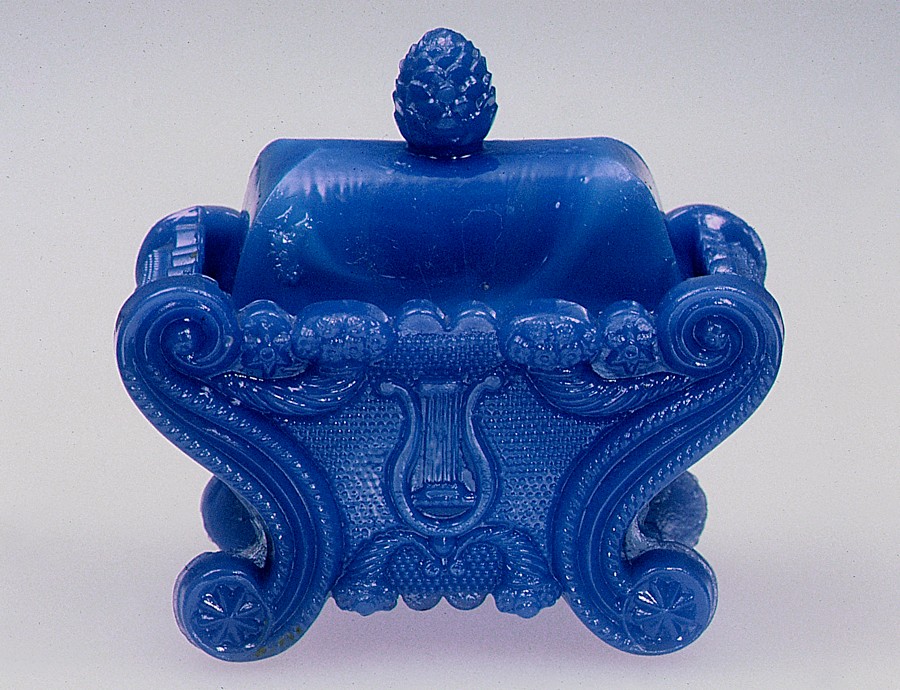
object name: salt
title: Covered salt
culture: american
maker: boston & sandwich glass company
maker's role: maker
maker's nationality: american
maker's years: 1825-1888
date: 1830-1840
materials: glass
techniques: pressed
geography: united states